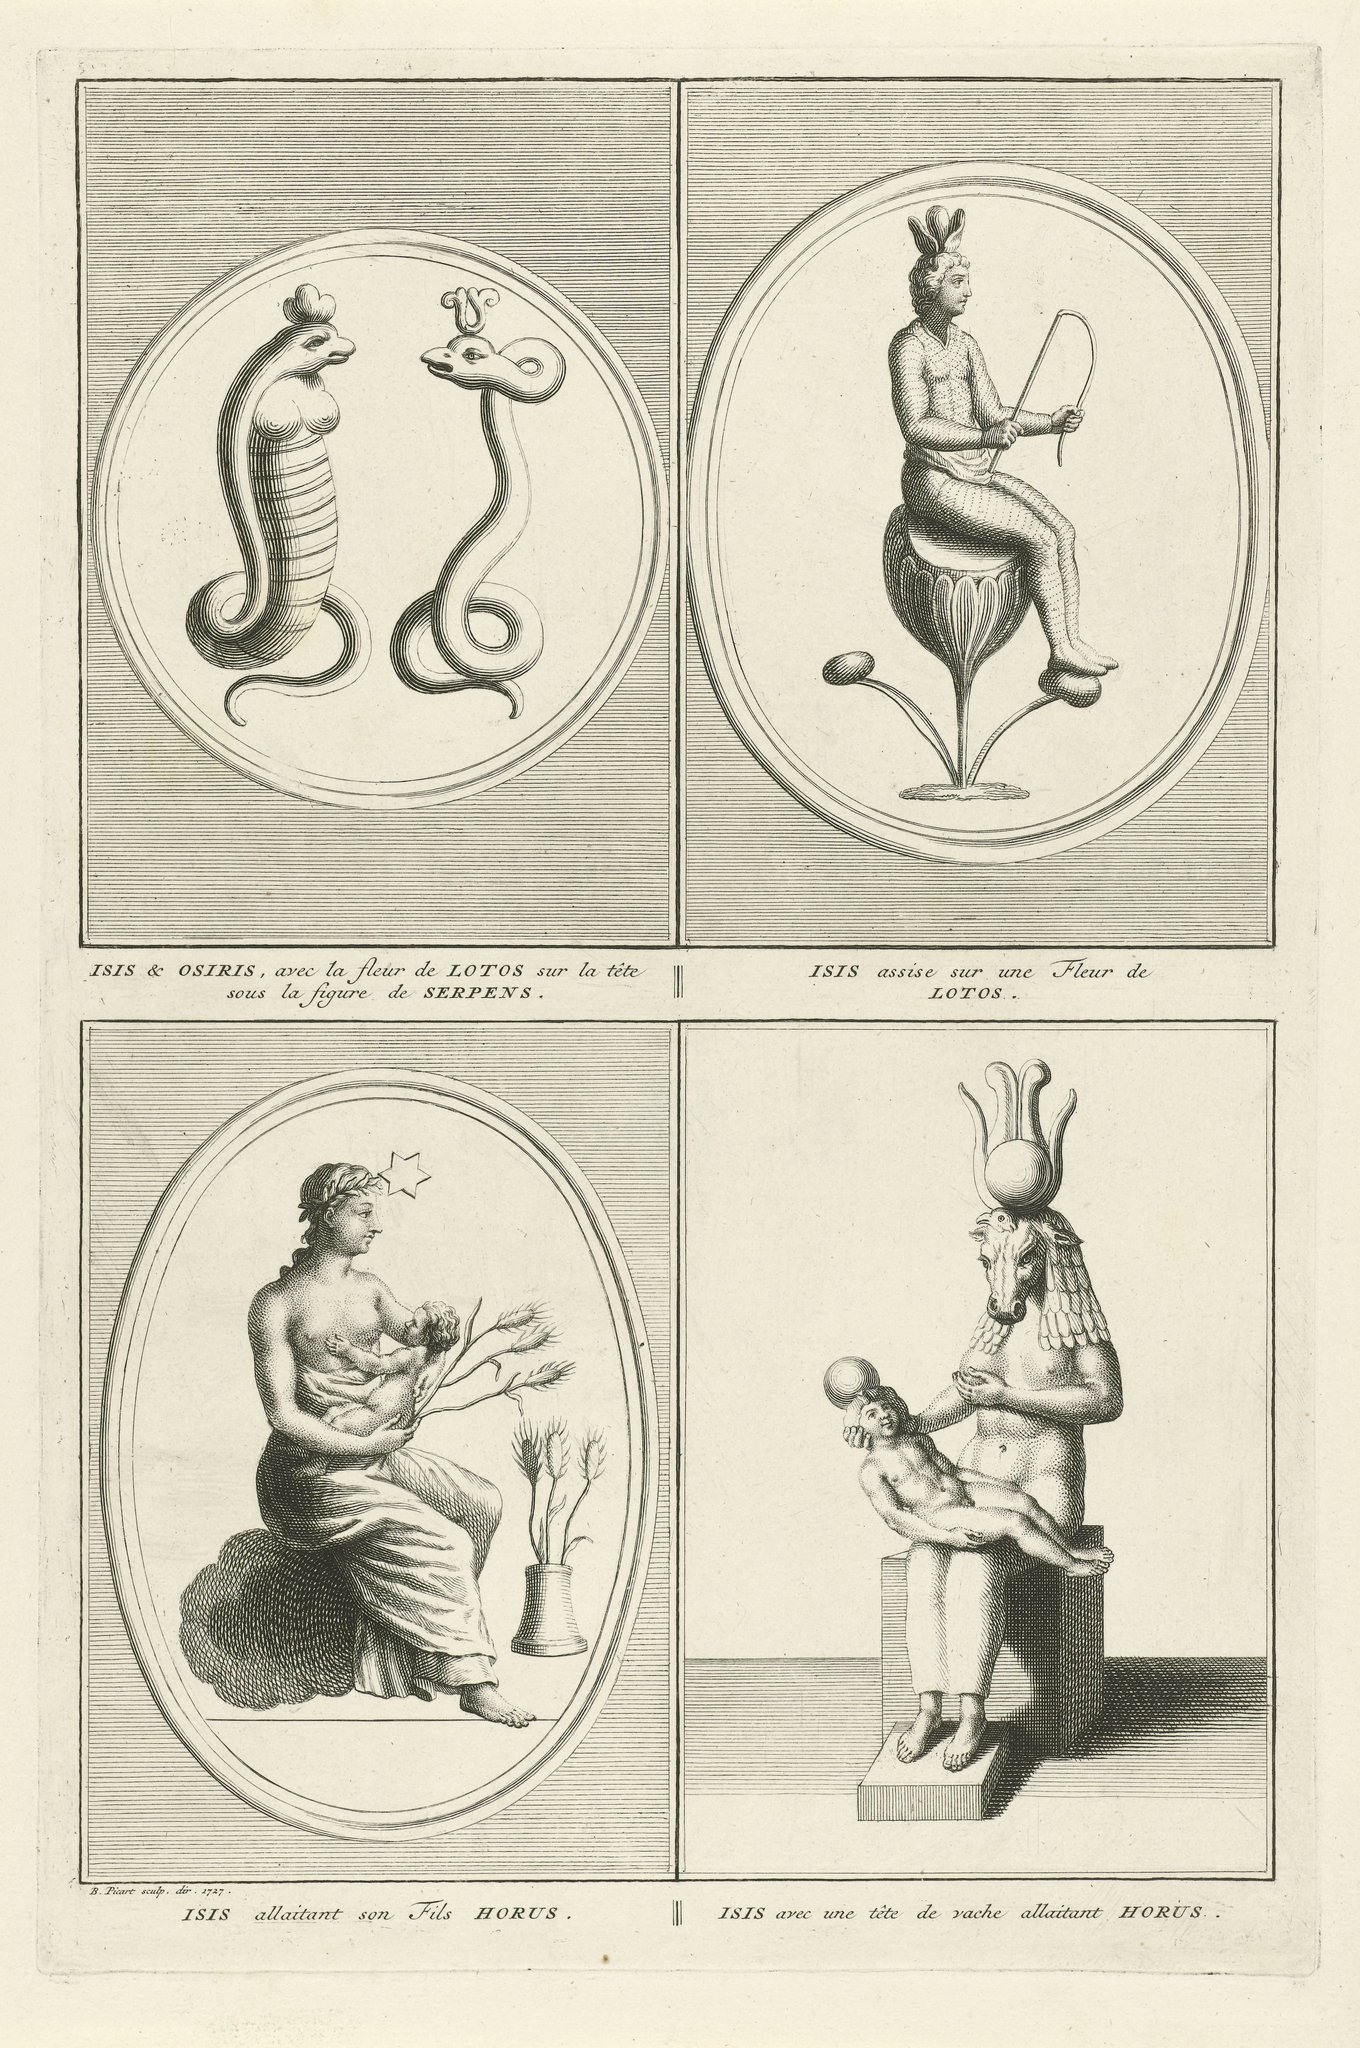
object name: print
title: Verschillende gedaantes van Egyptische goden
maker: bernard picart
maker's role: draughtsman, print maker, publisher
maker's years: 1673-1733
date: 1727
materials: paper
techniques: engraving, etching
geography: amsterdam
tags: isis, the mother-goddess, horus, son of osiris and isis, osiris, god of the underworld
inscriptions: collector's mark: Lugt 2228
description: Prent ook gebruikt in: Picart, Bernard. Naaukeurige beschryving der uitwendige godtsdienst-plichten, kerk-zeden en gewoontens van alle volkeren der waereldt, deel IV. [Vertaald in het Nederlands door] Moubach, Abraham. Den Haag, Amsterdam, Rotterdam: Rutgert Alberts, Hermannus Uytwerf, Jan Daniel Beman, Isaac van der Kloot, 1727-1738.